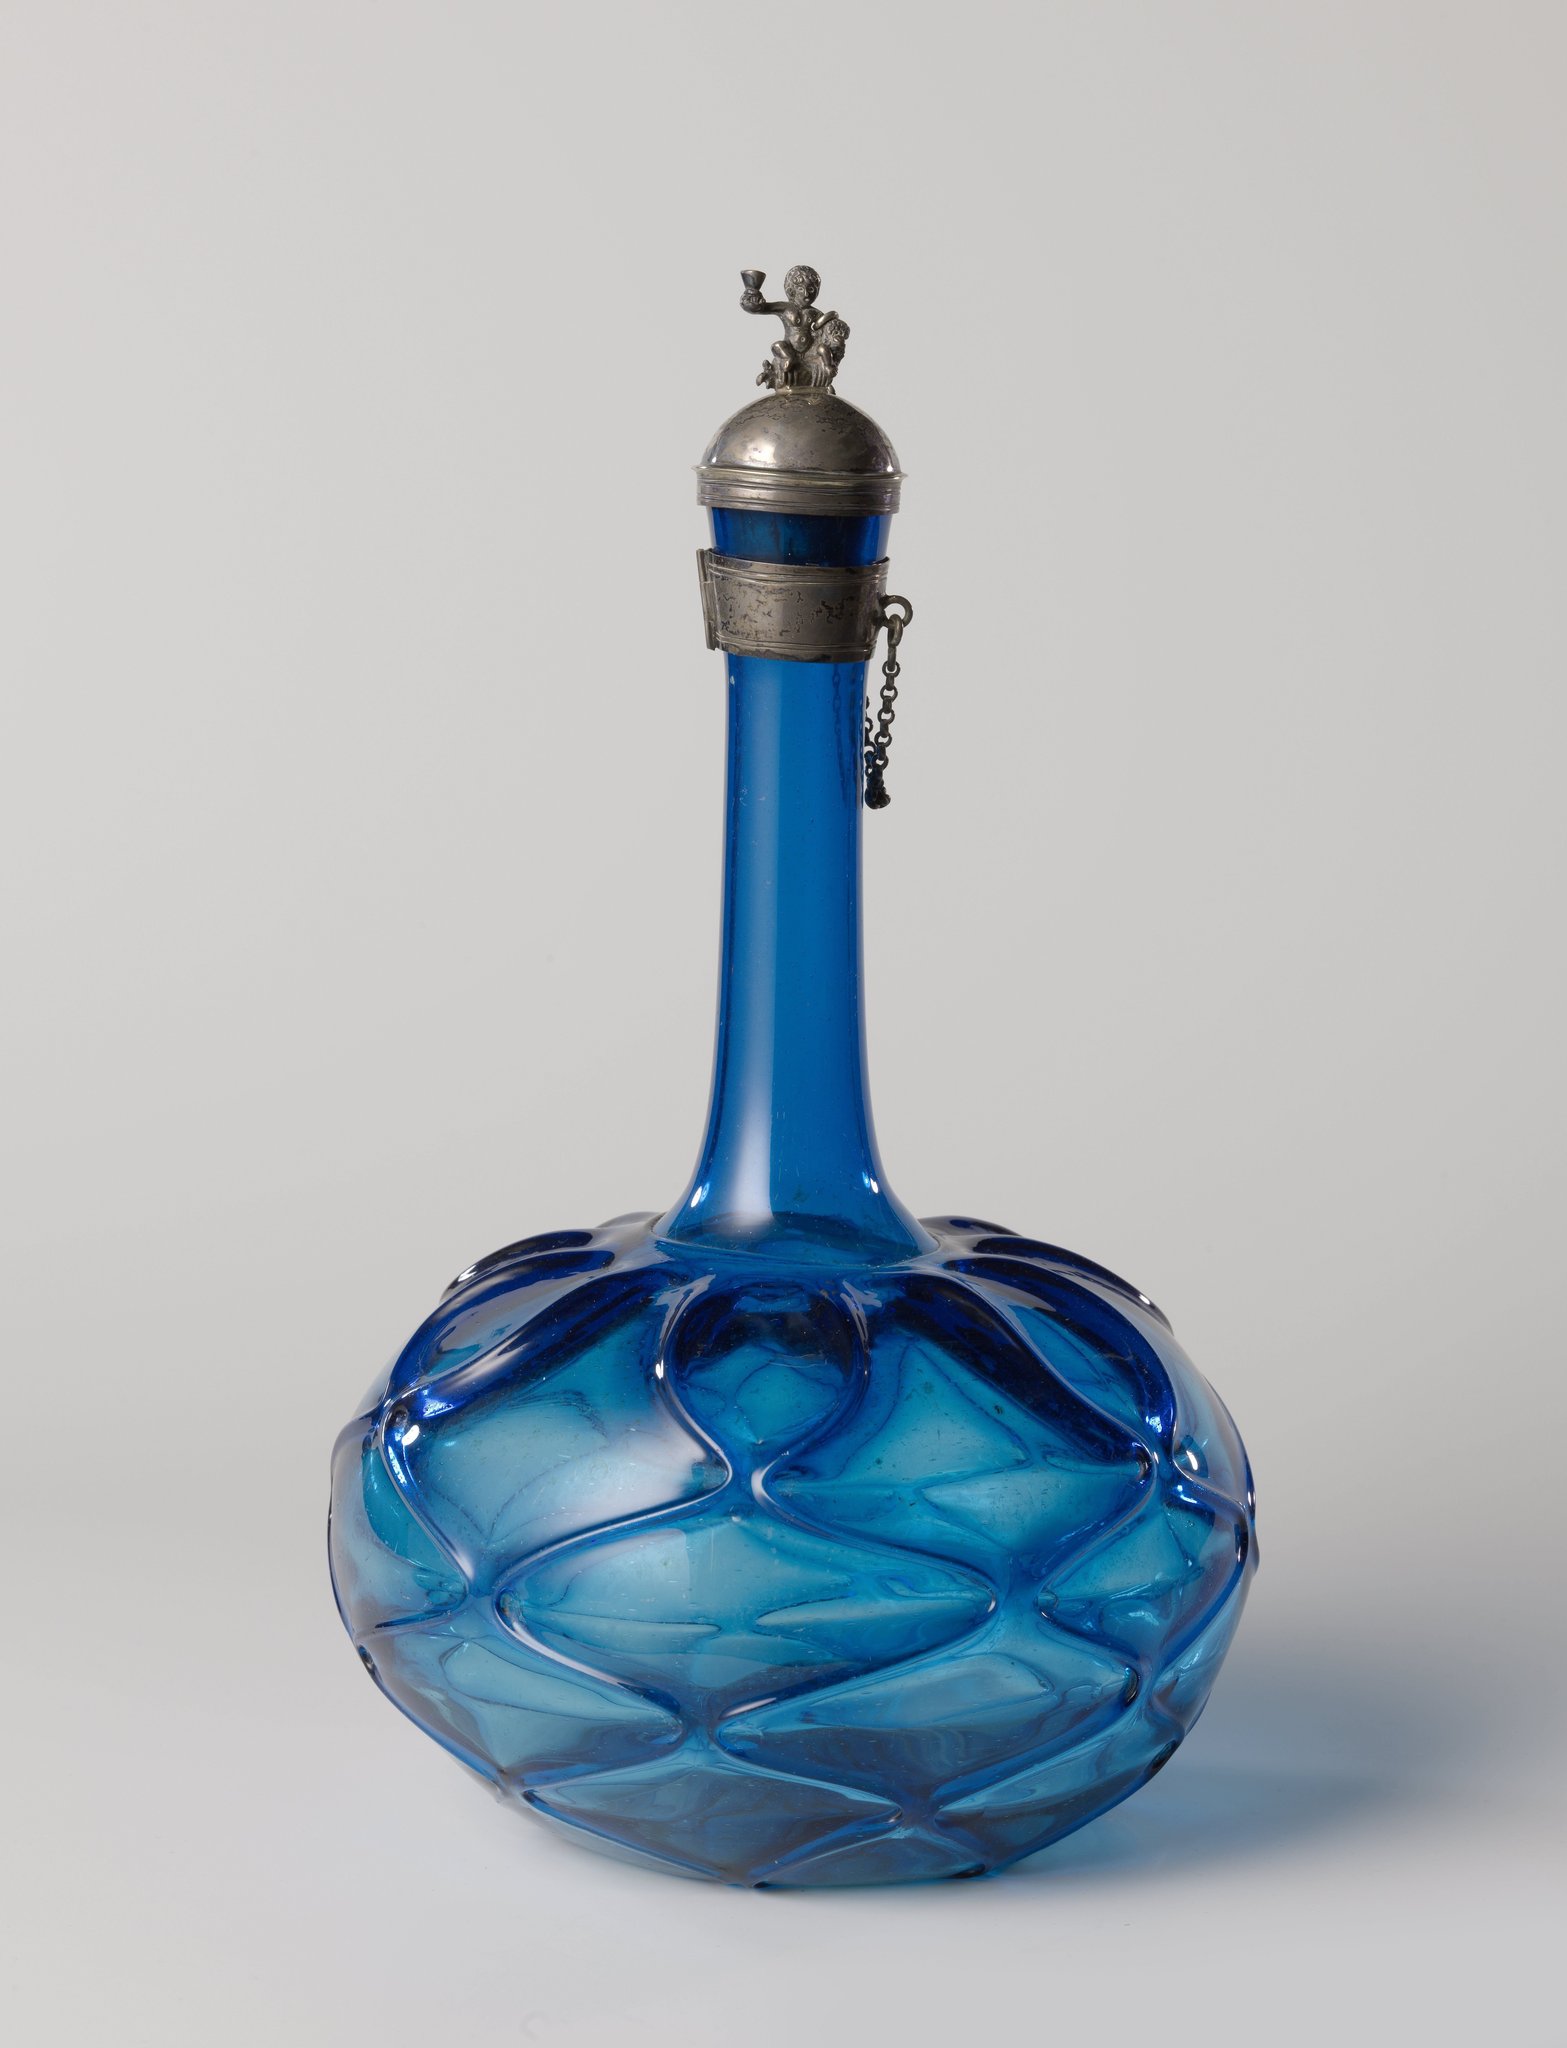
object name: carafe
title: Karaf met bolvormig lichaam met ruitmotief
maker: Anonymous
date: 1650-1700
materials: glass, silver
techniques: glassblowing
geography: northwest europe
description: Ingestoken ziel, gedrukt bolvormig lichaam van twee lagen glas, de buitenste in een ruitmotief. Hoge, slanke hals, c. twee cm onder de rand resten van een druipring, die schuil gaan onder een zilveren band. De bolle zilveren stop, met een kettinkje aan de band bevestigd, wordt bekroond door Bacchus, die zijn glas heft.